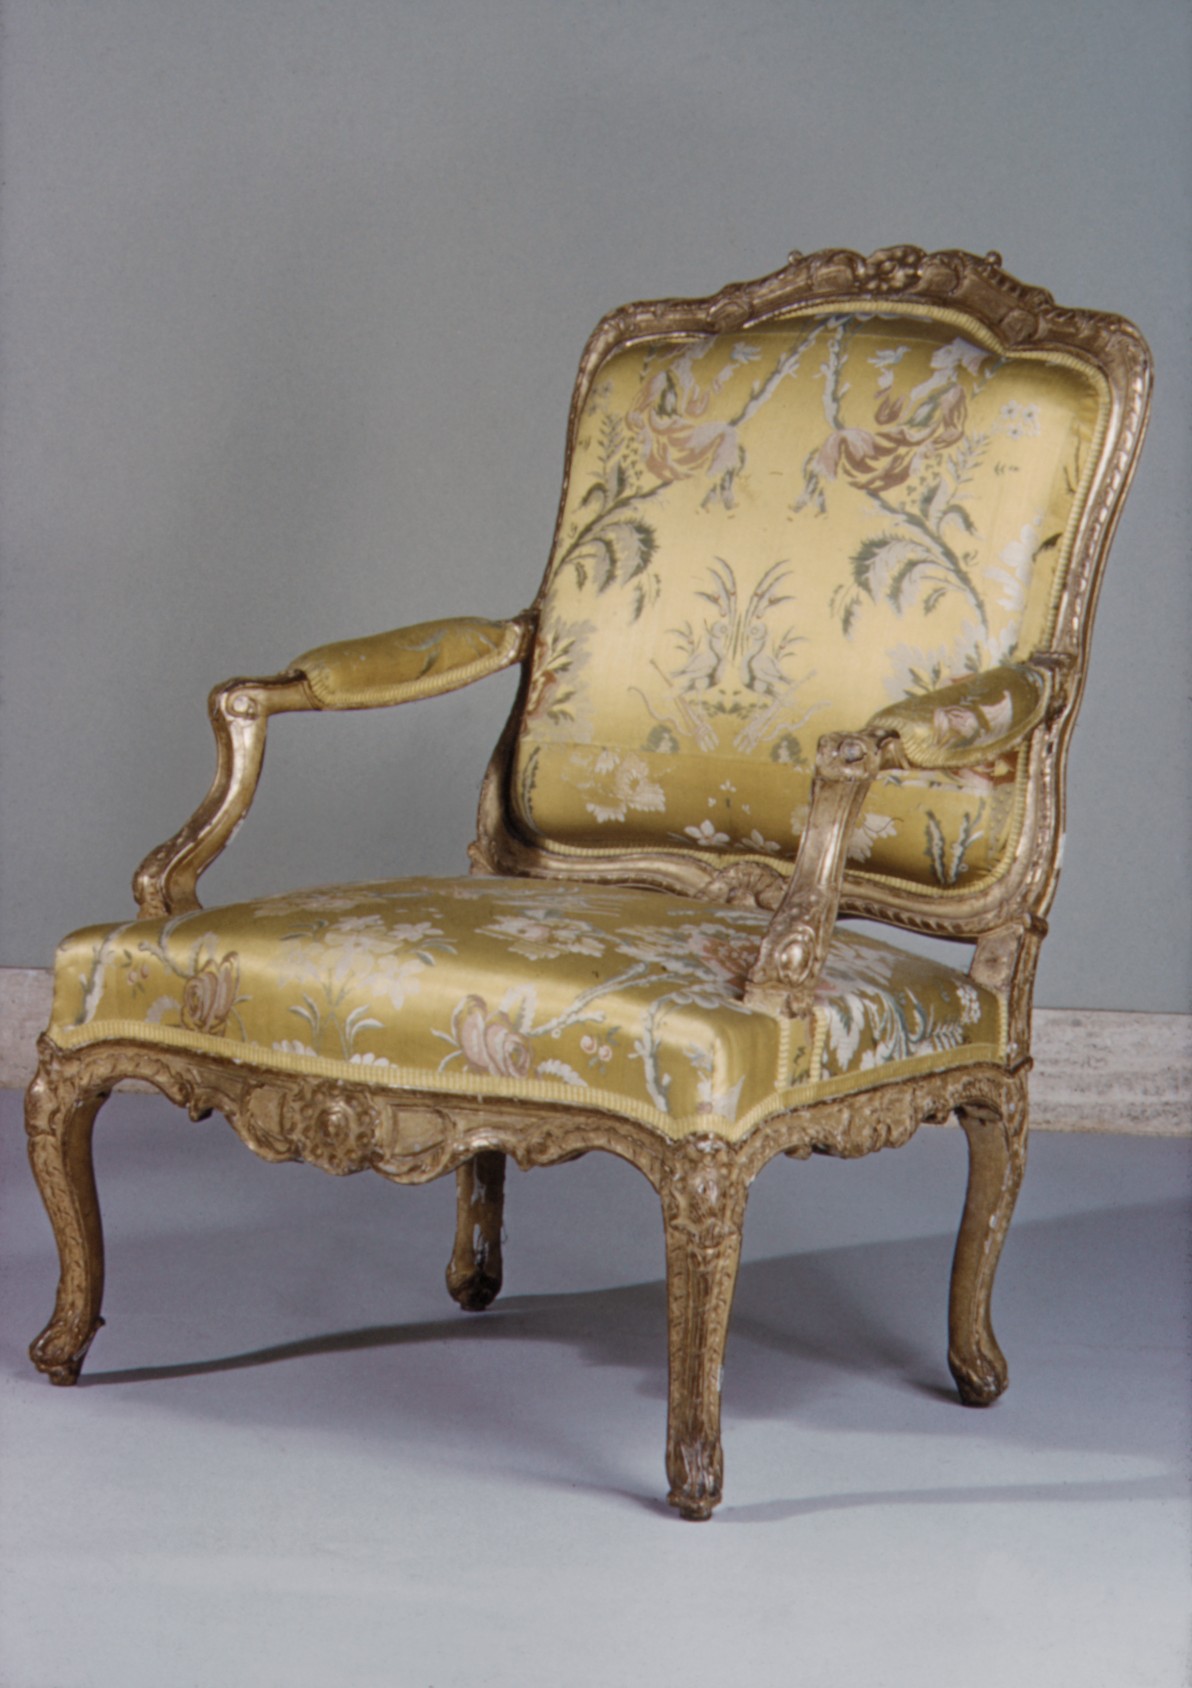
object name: armchair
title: Pair of armchairs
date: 1715-1723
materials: wood, silk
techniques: carving, gilding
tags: flowers